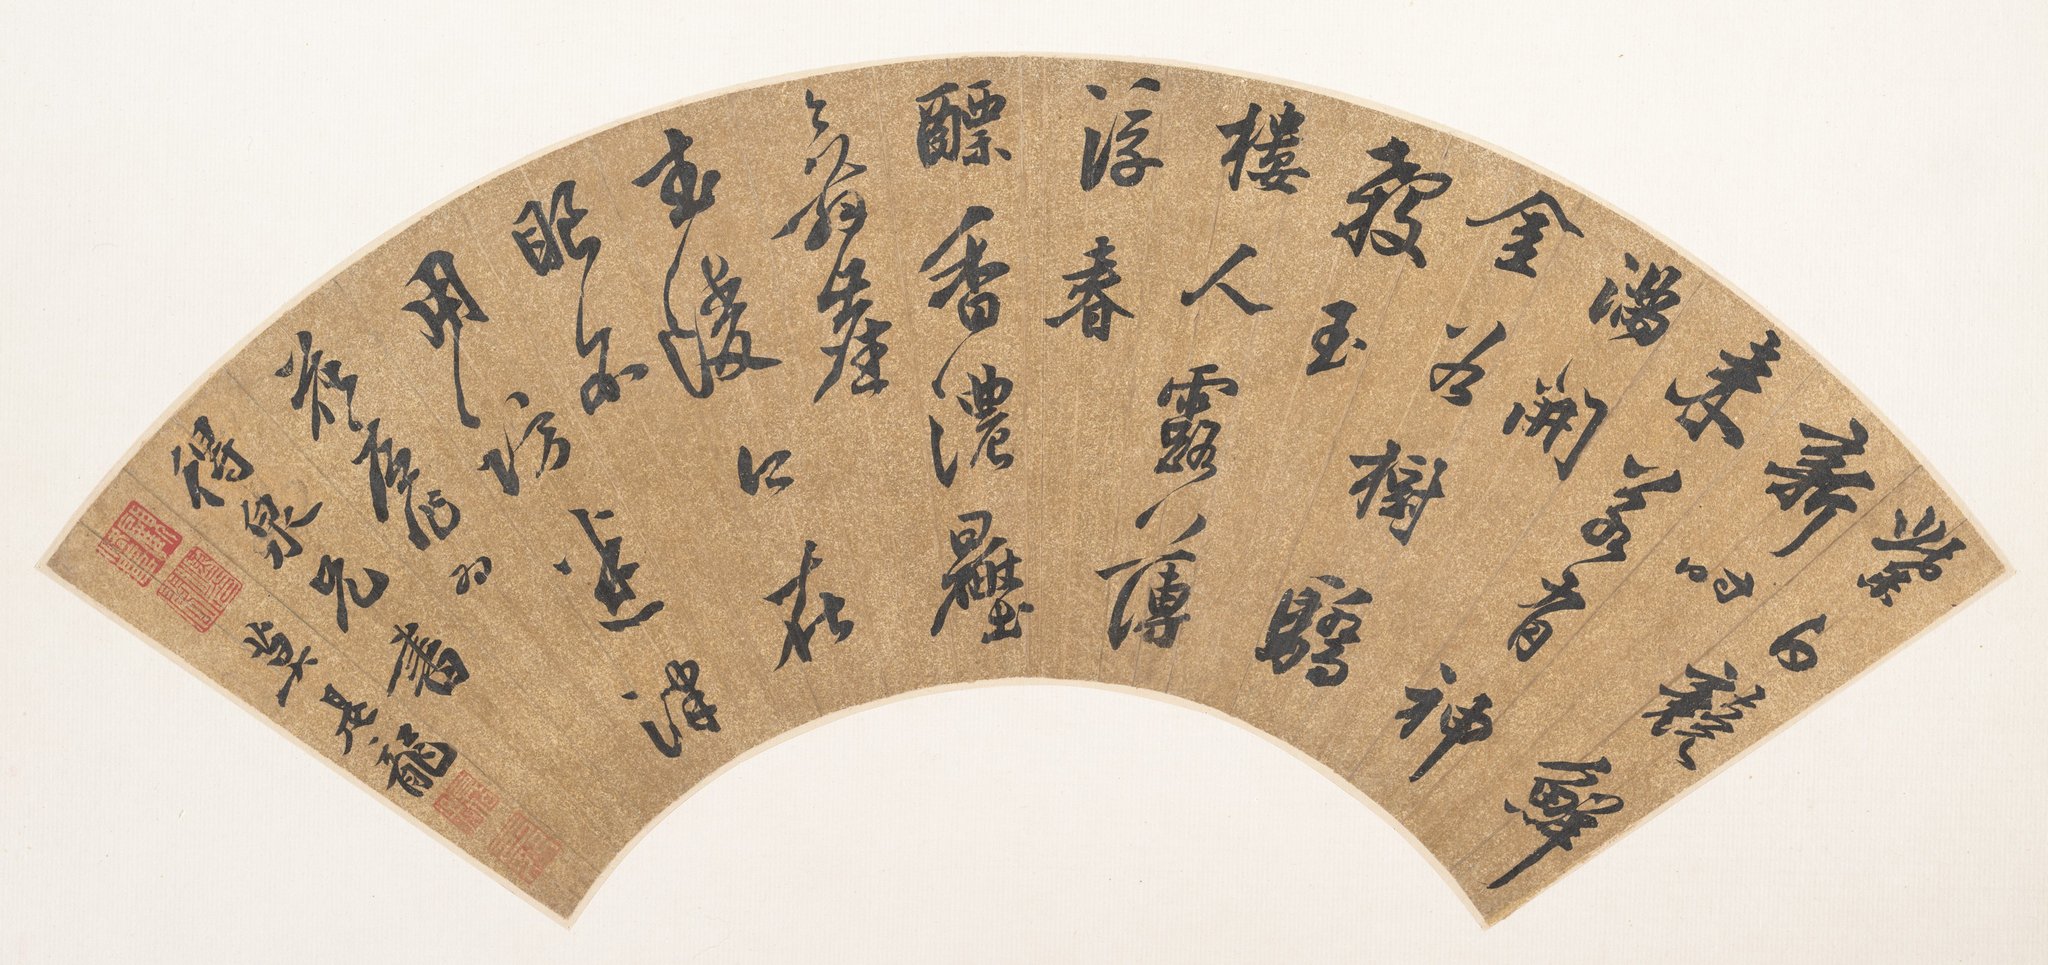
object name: folding fan mounted a an album leaf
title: Spring Garden in Bloom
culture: chinese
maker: mo shilong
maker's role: artist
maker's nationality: chinese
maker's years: 1537-1587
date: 1537-1587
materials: gold, ink, paper